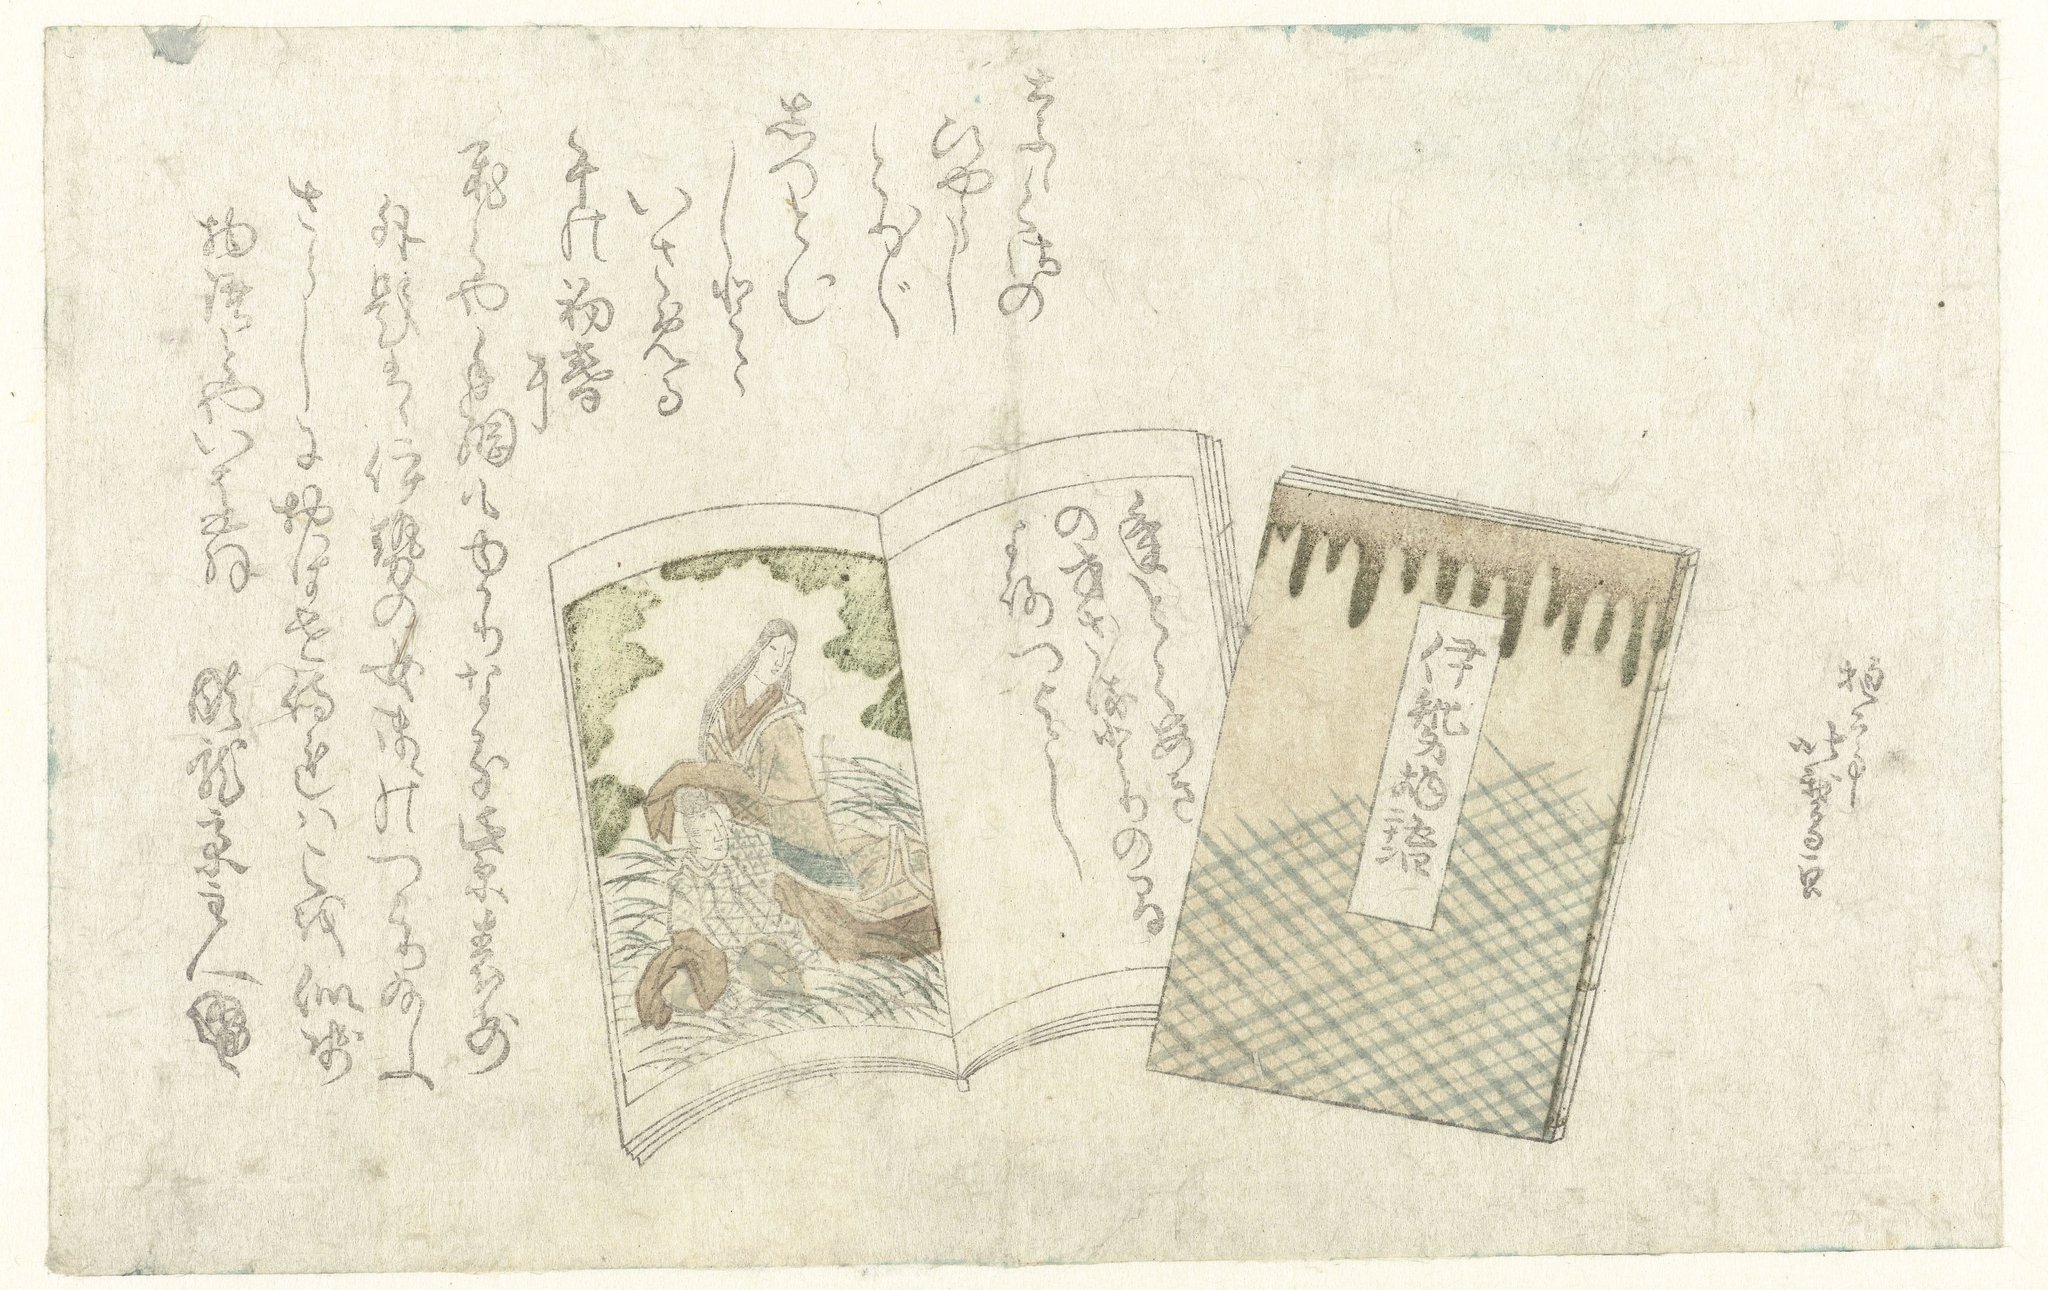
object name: surimono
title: Two Books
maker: katsushika hôtei hokuga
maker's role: print maker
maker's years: 1780-1856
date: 1810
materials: paper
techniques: woodcut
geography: japan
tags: book - mm - book open, book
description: Een surimono is een luxe uitgevoerde prent waarop beeld met één of meerdere gedichten gecombineerd is. Bij het drukken van een surimono werd vaak gebruik gemaakt van dikker papier, blinddruk en metaal pigmenten, zoals koper- en zilverpoeder. De prenten werden vaak in opdracht van dichters gemaakt en als exclusief geschenk aan vrienden en relaties gegeven. Een egoyomi is een kalender prent, waarop de aanduiding voor de maanden verstopt zit in het ontwerp. Vaak werden egoyomi net als surimono in eigen beheer uitgegeven en aan vrienden kado gedaan. In Japan gebruikte men tot 1873 een maankalender, waarbij de volgorde van de lange en de korte maanden jaarlijks varieerde. Omdat er maar een klein aantal uitgevers kalenders mocht maken, waren particulier uitgeven kalender prenten tegen de regels van de overheid. Om deze regels te omzeilen werden de kalendergegevens verstopt in het prentontwerp.